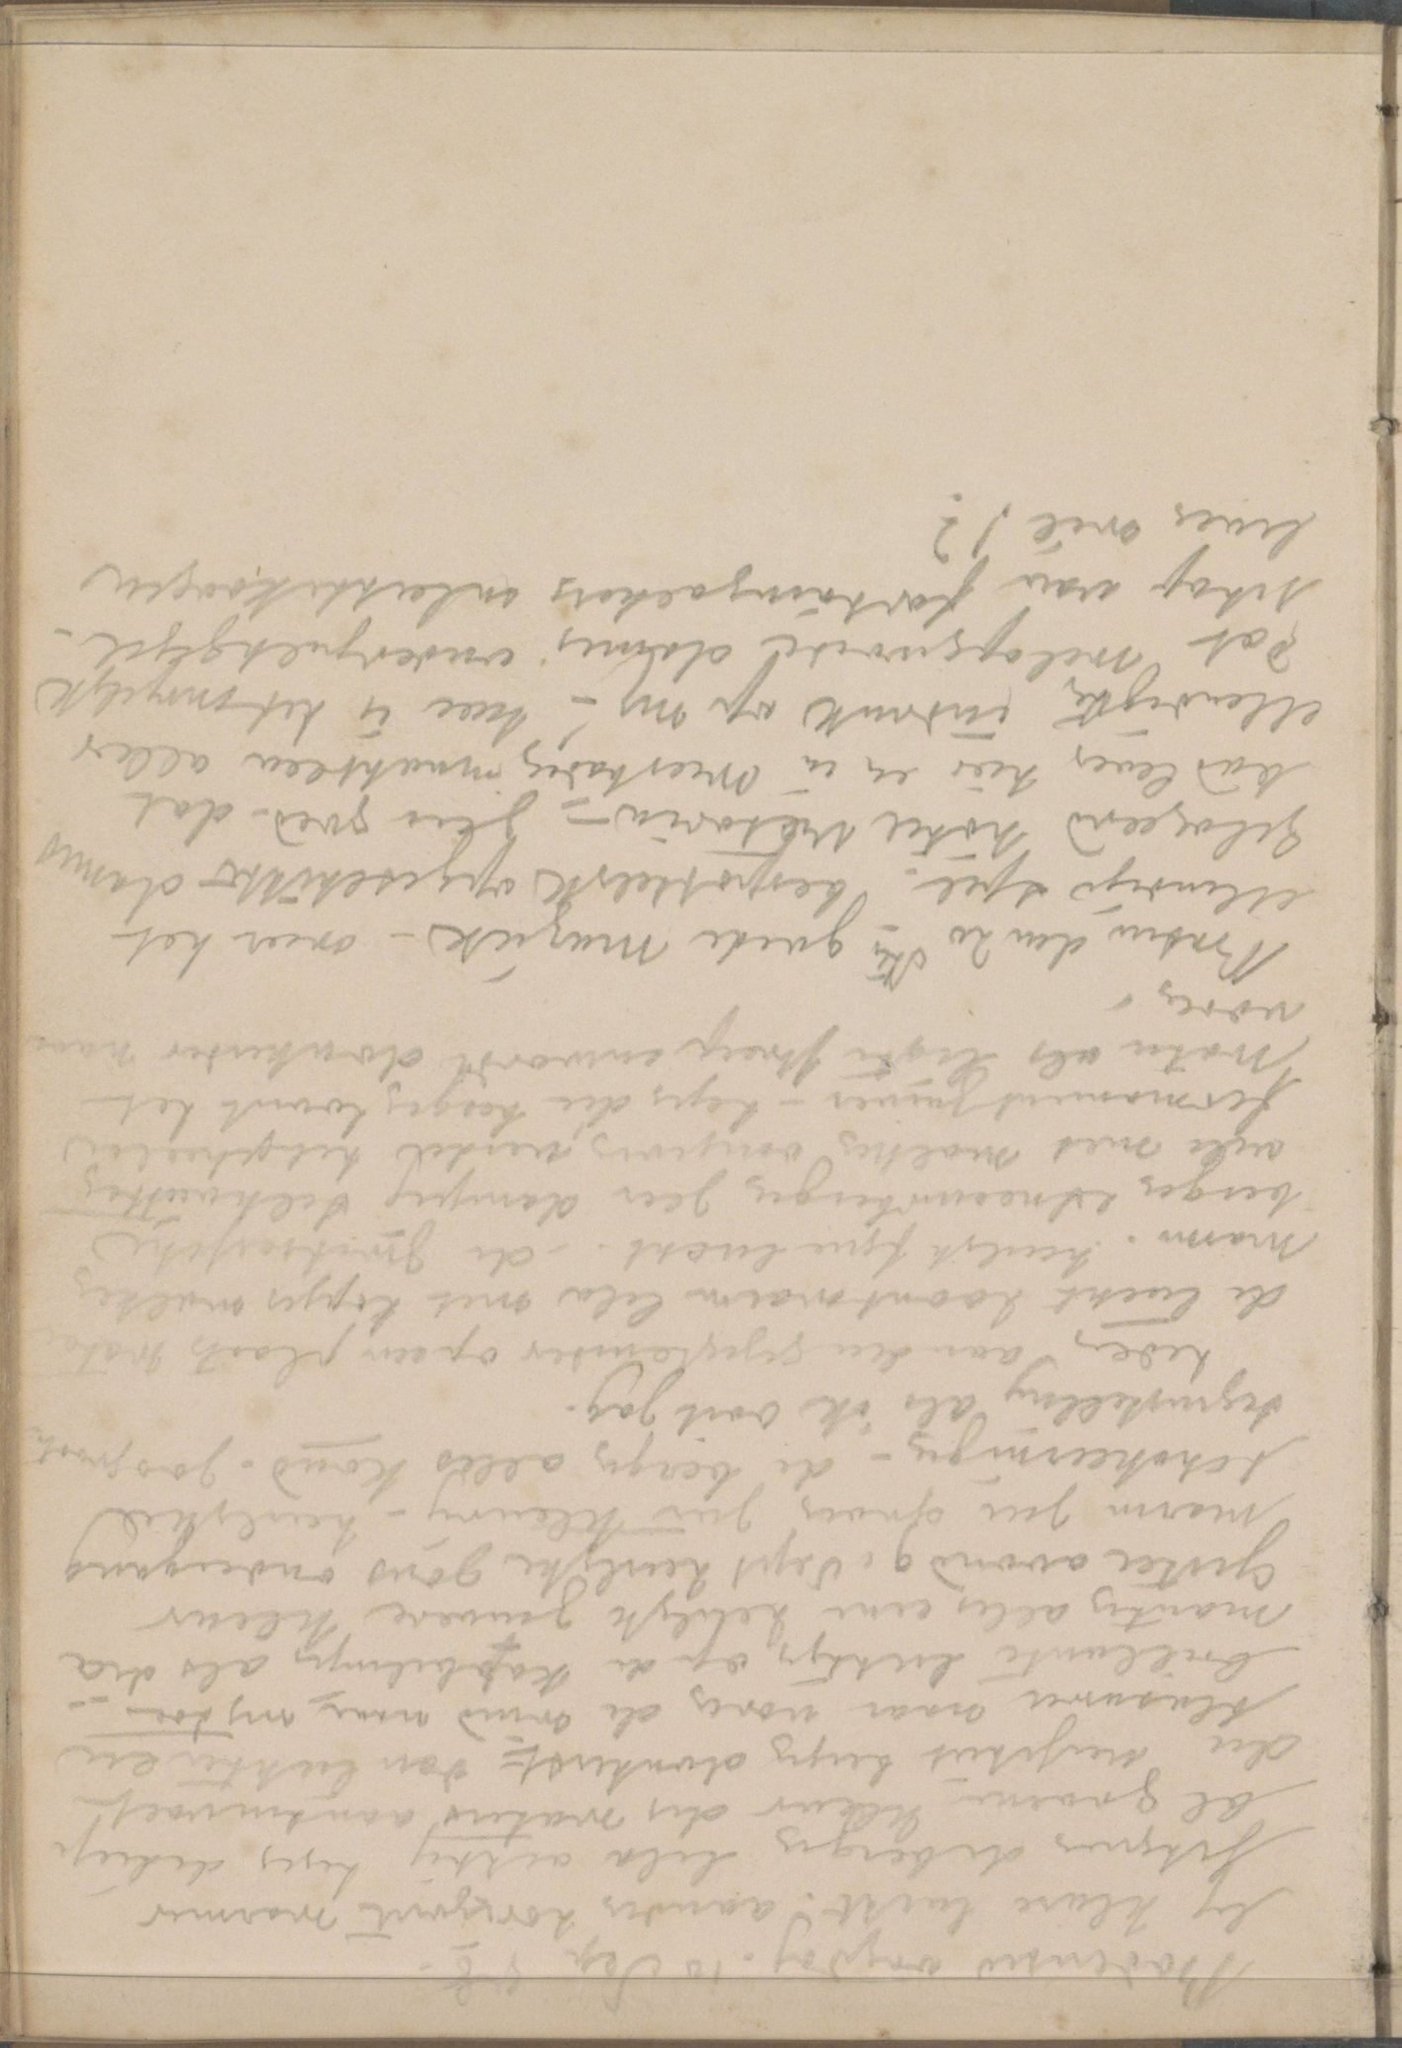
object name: sketchbook leaf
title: Notities over het Bodenmeer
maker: johannes tavenraat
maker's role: draughtsman, painter, print maker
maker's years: 1809-1881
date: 1809-1858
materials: paper, pencil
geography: lake constance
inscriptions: date and inscription: ‘Bodenzee vrijdag. 10 Sep 58 [...]’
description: Blad 45 verso uit een schetsboek met 47 bladen.